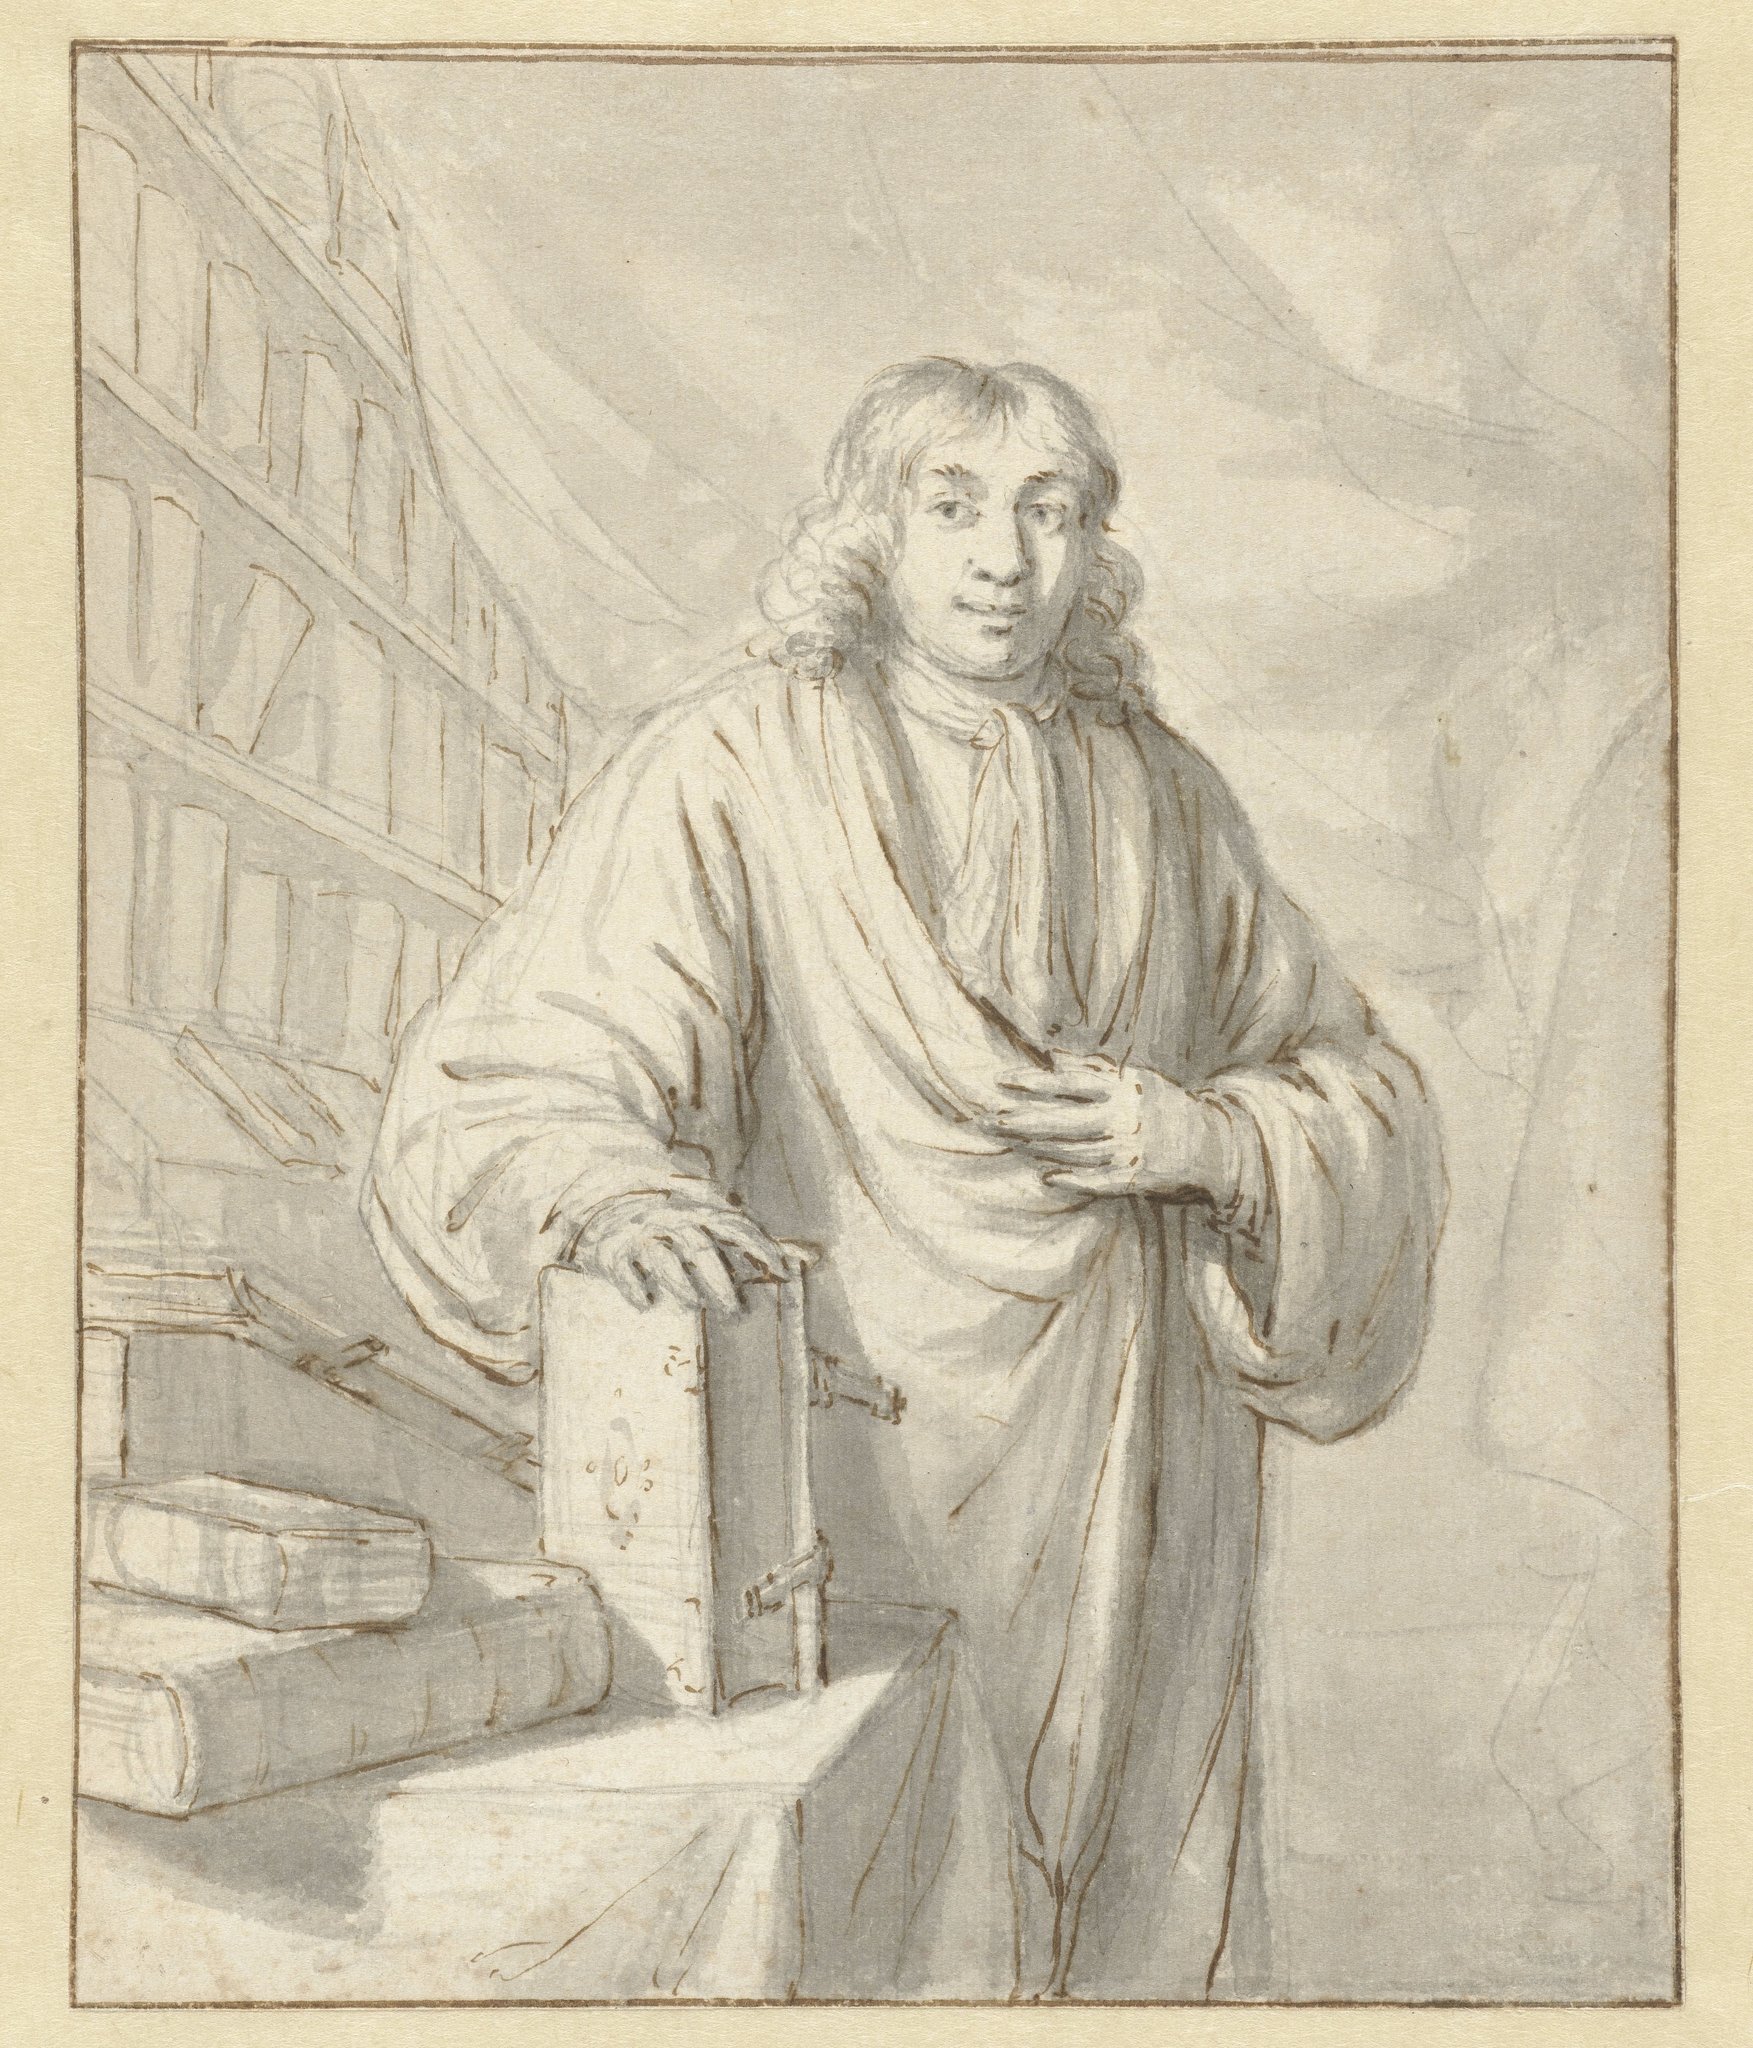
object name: drawing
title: Portret van Hugo van der Helst, staand in zijn bibliotheek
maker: jan verkolje (i)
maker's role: draughtsman, painter, print maker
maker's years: 1650-1693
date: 1660-1693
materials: ink, paper, pencil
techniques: brush, pen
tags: historical persons, study; 'studiolo'; library